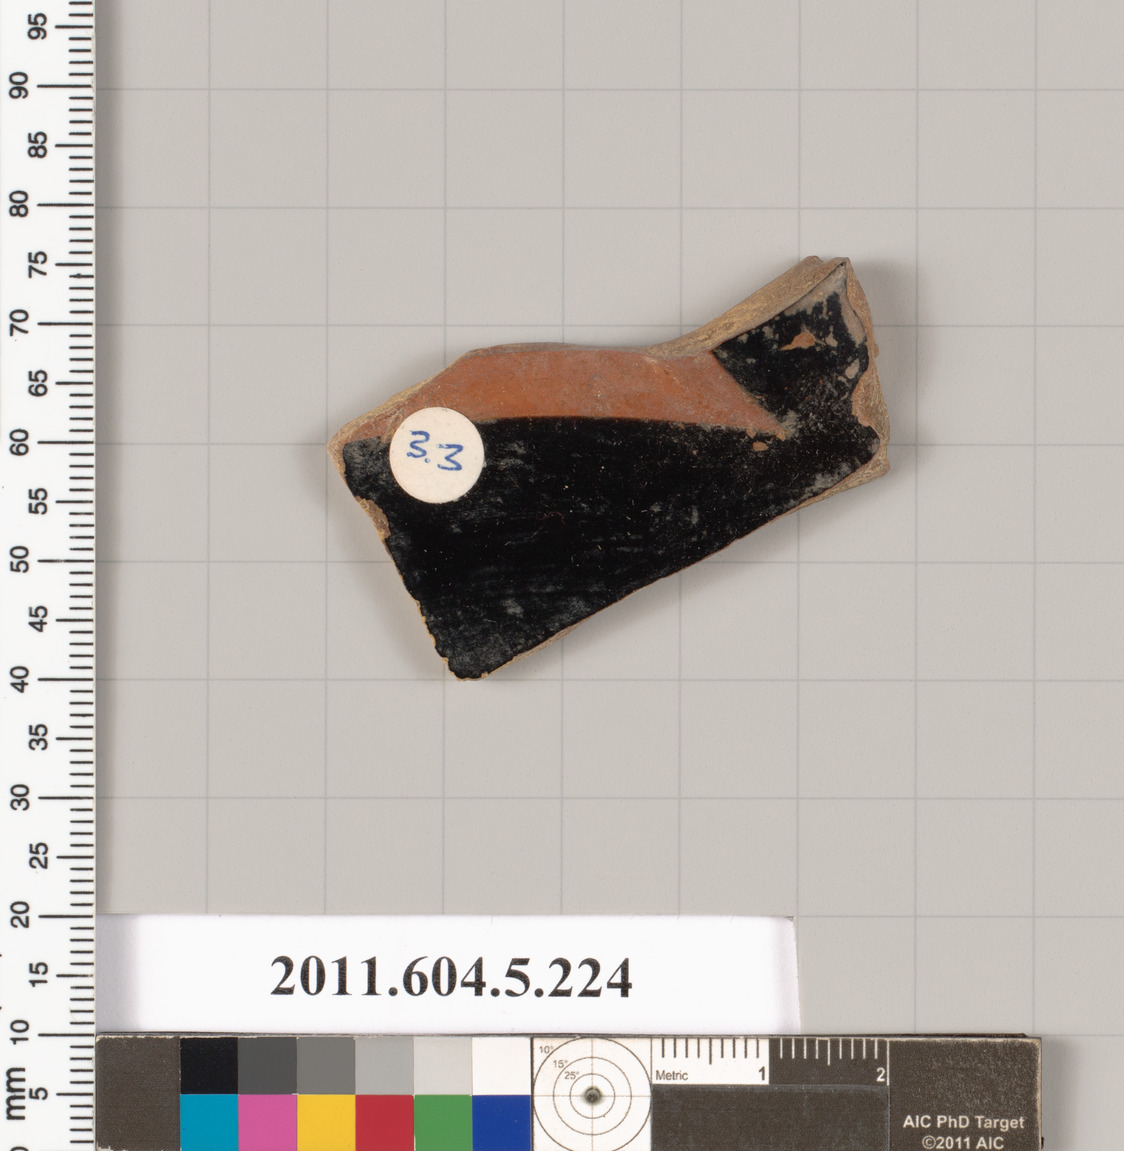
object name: kylix fragment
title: Terracotta fragment of a kylix (drinking cup)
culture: greek, attic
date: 600-401 BCE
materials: terracotta